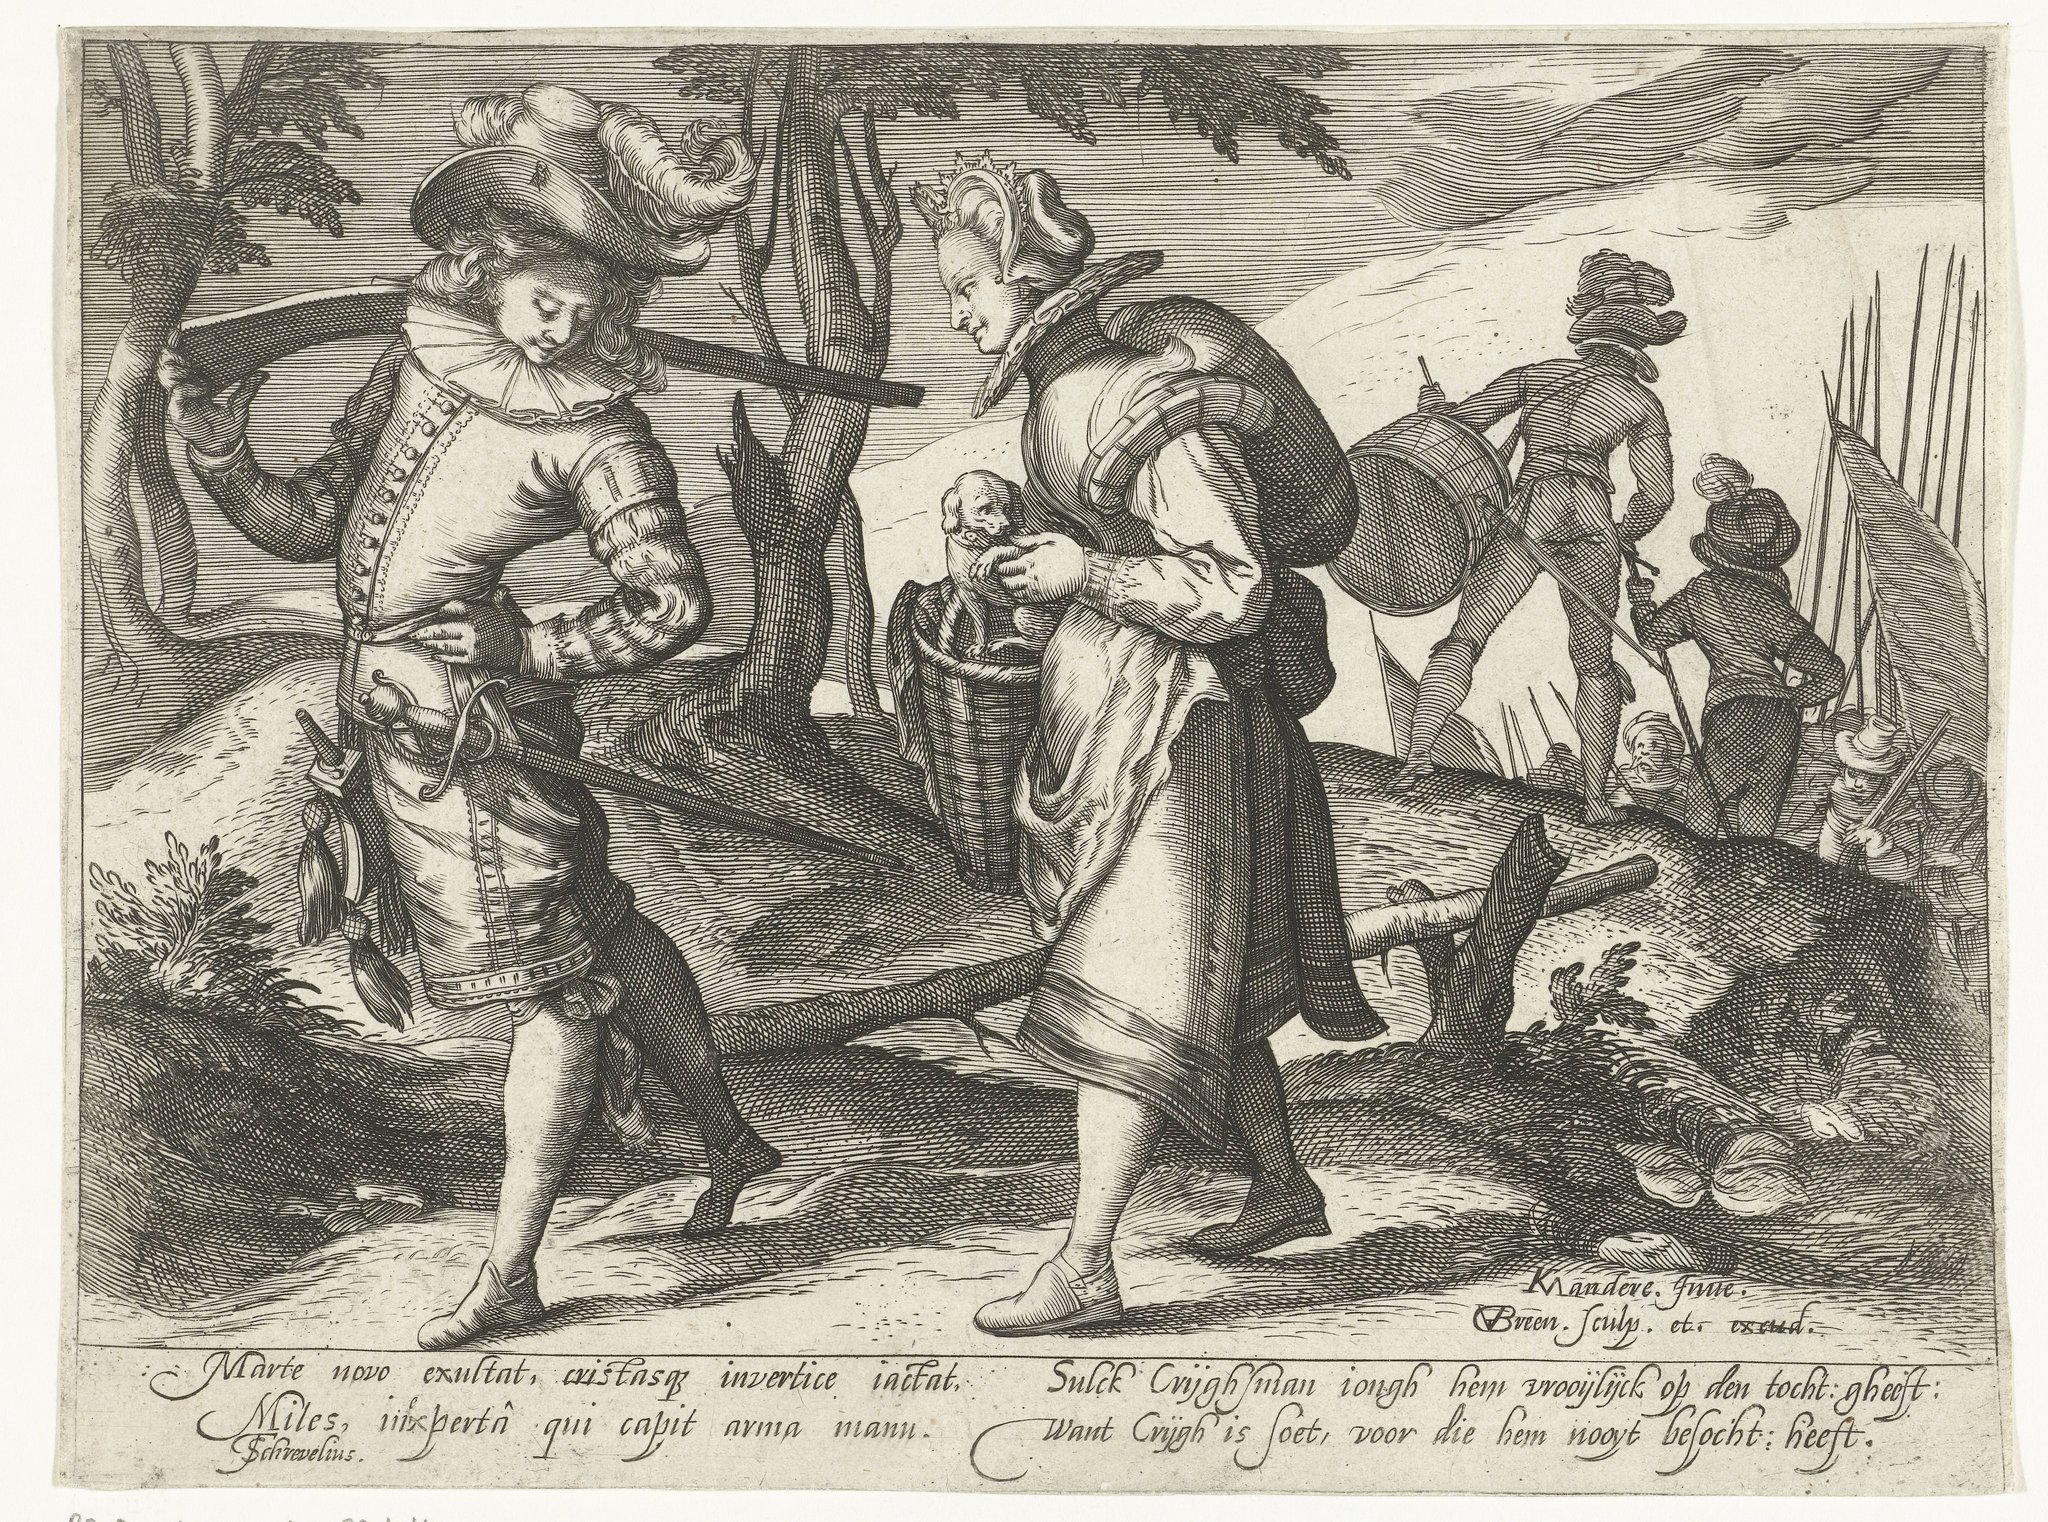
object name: print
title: Trotse soldaat met jonge vrouw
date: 1585-1610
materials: paper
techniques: engraving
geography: haarlem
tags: war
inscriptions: collector's mark: Lugt 2228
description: Links een jonge soldaat die met trots kijkt naar zijn uniform en wapen. Naast hem loopt een jonge vrouw, die een klein hondje in een mand meedraagt. De vrouw is waarschijnlijk een zoetelaarster, een vrouw die de was en het koken voor een legereenheid verzorgde en met de soldaten meereisde. Op de achtergrond is het leger te zien dat in de oorlog trekt. Met een Latijns onderschrift van Theodor Schrevelius en een Nederlands vers.